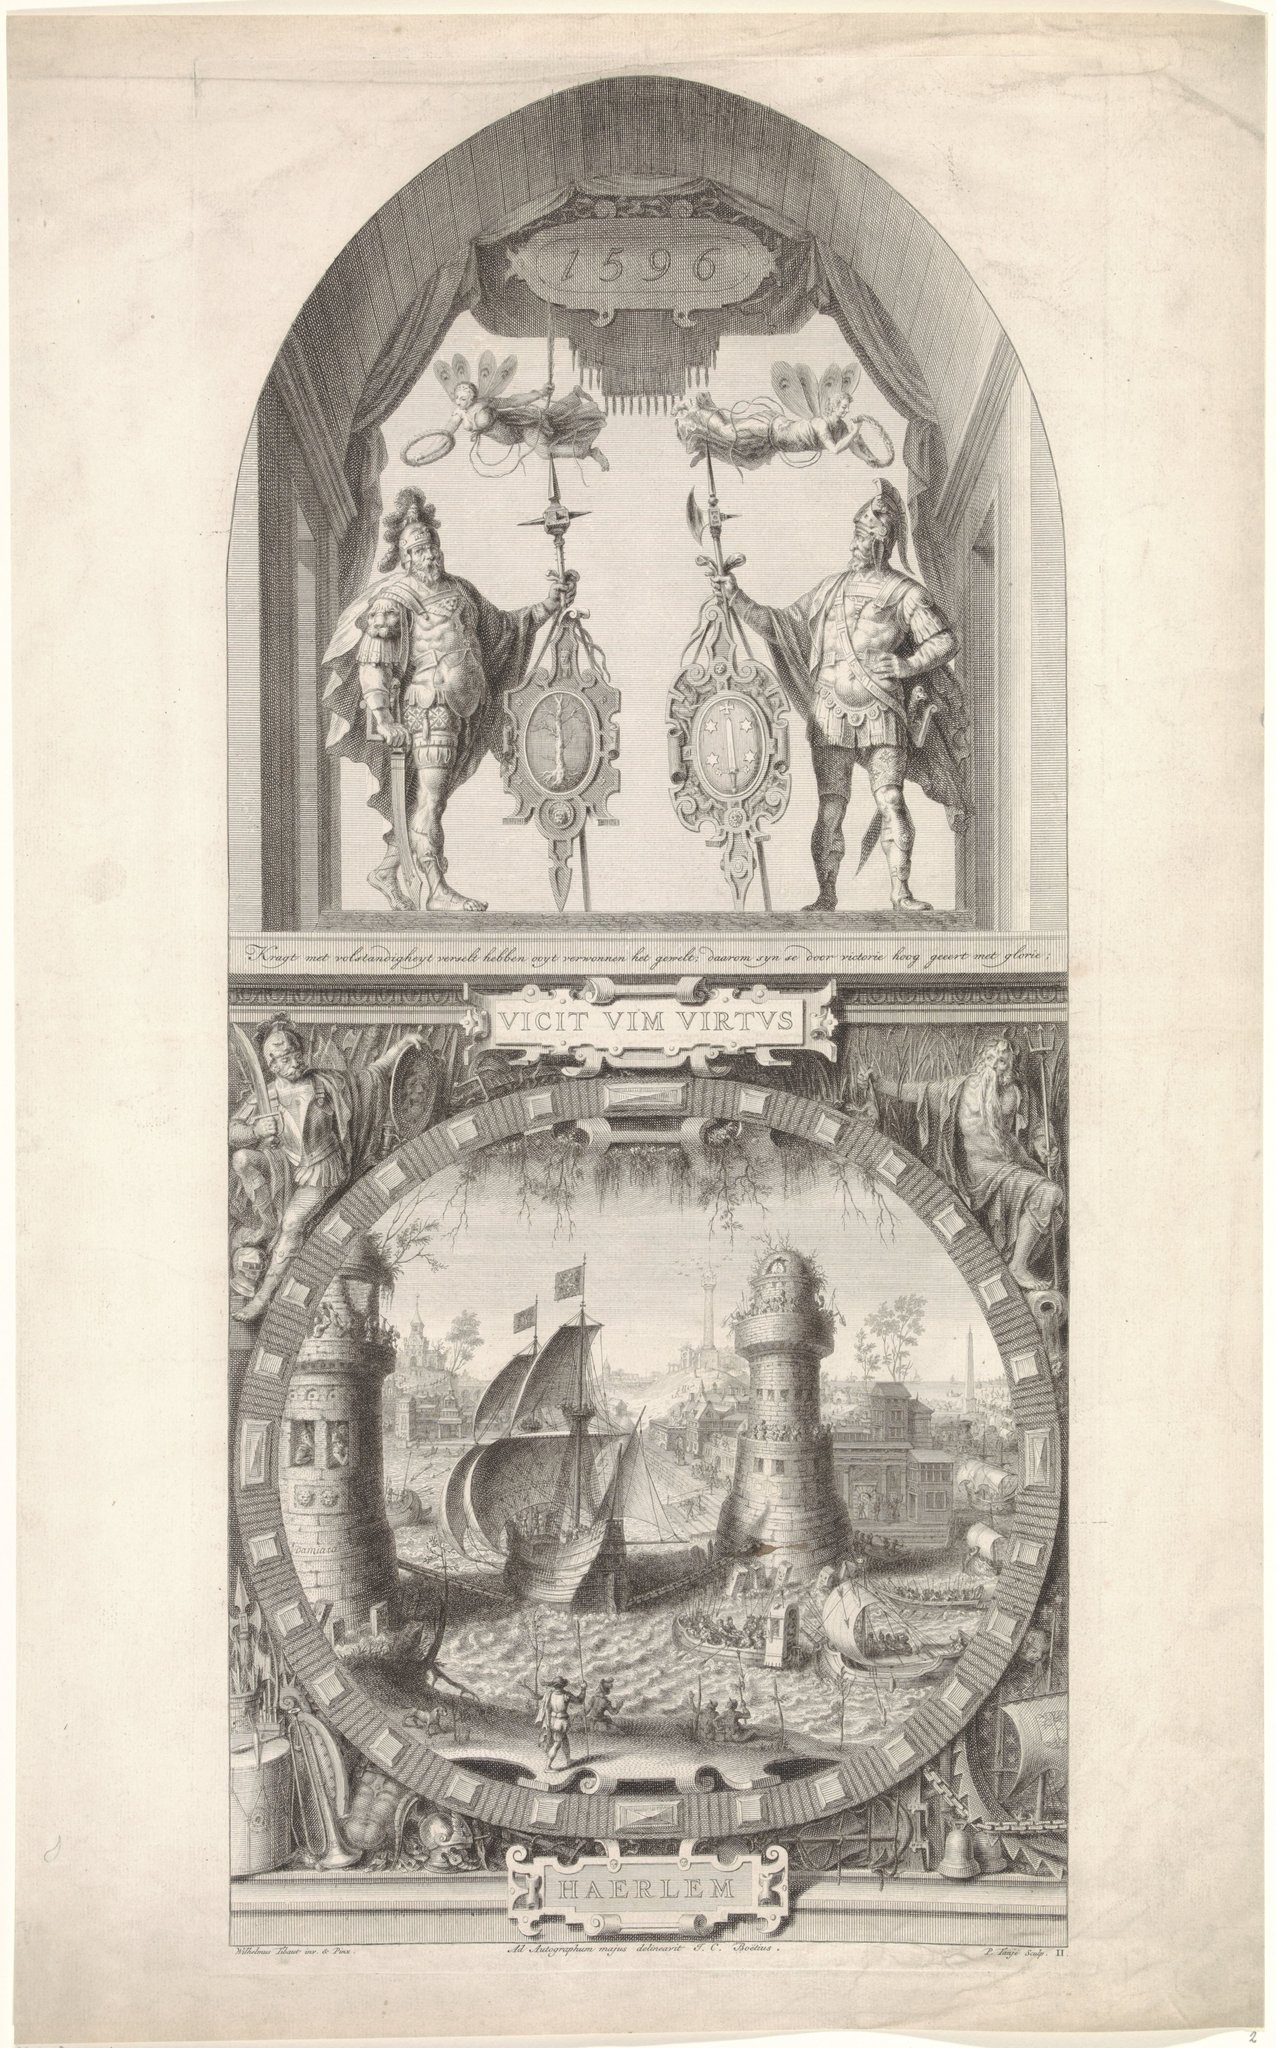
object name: print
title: Goudse glazen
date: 1738-1754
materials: paper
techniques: engraving, etching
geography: amsterdam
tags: church-window, e.g. rose-window, fortifications, military engineering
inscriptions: collector's mark: Lugt 2228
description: Het tweede glasraam in de Sint-Janskerk te Gouda met onder de voorstelling van de inname van de stad Damiate door de Haarlemse kruisridders en het stukvaren van de ketting die de haven afsloot, 1219. Boven twee krijgers met het oude en het nieuwe wapen van Haarlem en het jaartal 1596. De stad Haarlem is de schenker van het glasraam aan de stad Gouda.